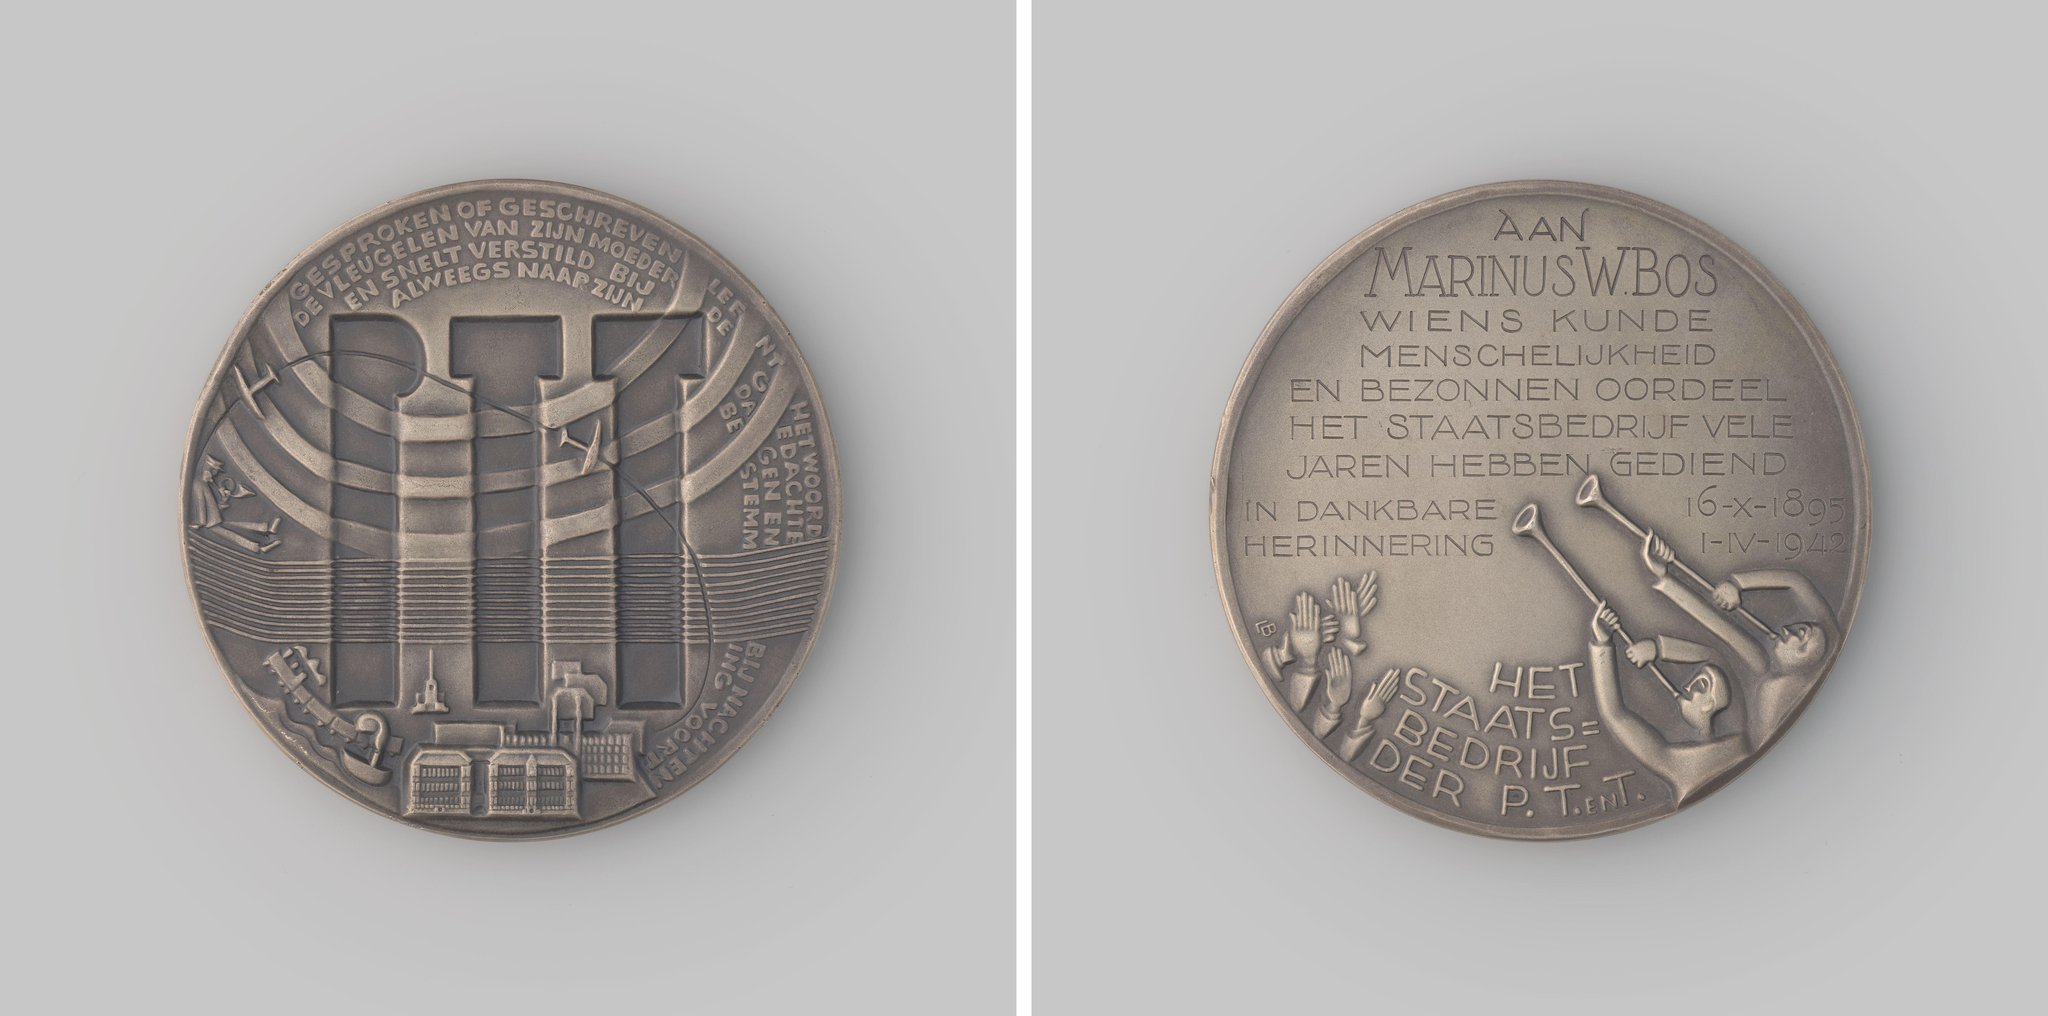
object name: honorary medal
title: Medal of Honour from the State-owned Enterprise PTT awarded to Marinus W. Bos in 1942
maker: leendert bolle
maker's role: painter, sculptor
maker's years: 1879-1942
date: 1940-1942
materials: silver, wood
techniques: striking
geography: netherlands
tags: ptt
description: Geslagen zilveren penning. Voorzijde: drie gestileerde, diepliggende letters 'PTT', waardoorheen groot aantal lijnen, waaronder een losse lijn met twee vliegtuigen, met aan onderzijde een aantal gebouwen, waaronder het hoofdkantoor der PTT in Den Haag en een zendgebouw, en vervoermiddelen, waaronder een trein en een stoomschip en linksmidden een mannelijk figuur met een posthoorn; van linksboven naar rechtsonder aan de rand een vierregelig gedicht (van P.C. Boutens): "Gesproken of geschreven leent het woord / de vleugelen van zijn moeder de gedachte / en snelt verstild bij dagen en bij nachten / alweegs naar zijn besteming voort". Keerzijde: rechtonder vanuit rand twee klaroenspelende figuren en rechtsonder drie paar klappende handen, waartussen tekst "Het Staatsbedrijf der P.T. en T." Op vlak ingegraveerde tekst: "Aan / Marinus W. Bos / wiens kunde / menschelijkheid / en bezonnen oordeel / het staatsbedrijf vele / jaren hebben gediend / in dankbare / herinnering / 16-X-1895 / 1-IV-1942". Naast klappende handen het monogram van de kunstenaar (LB).